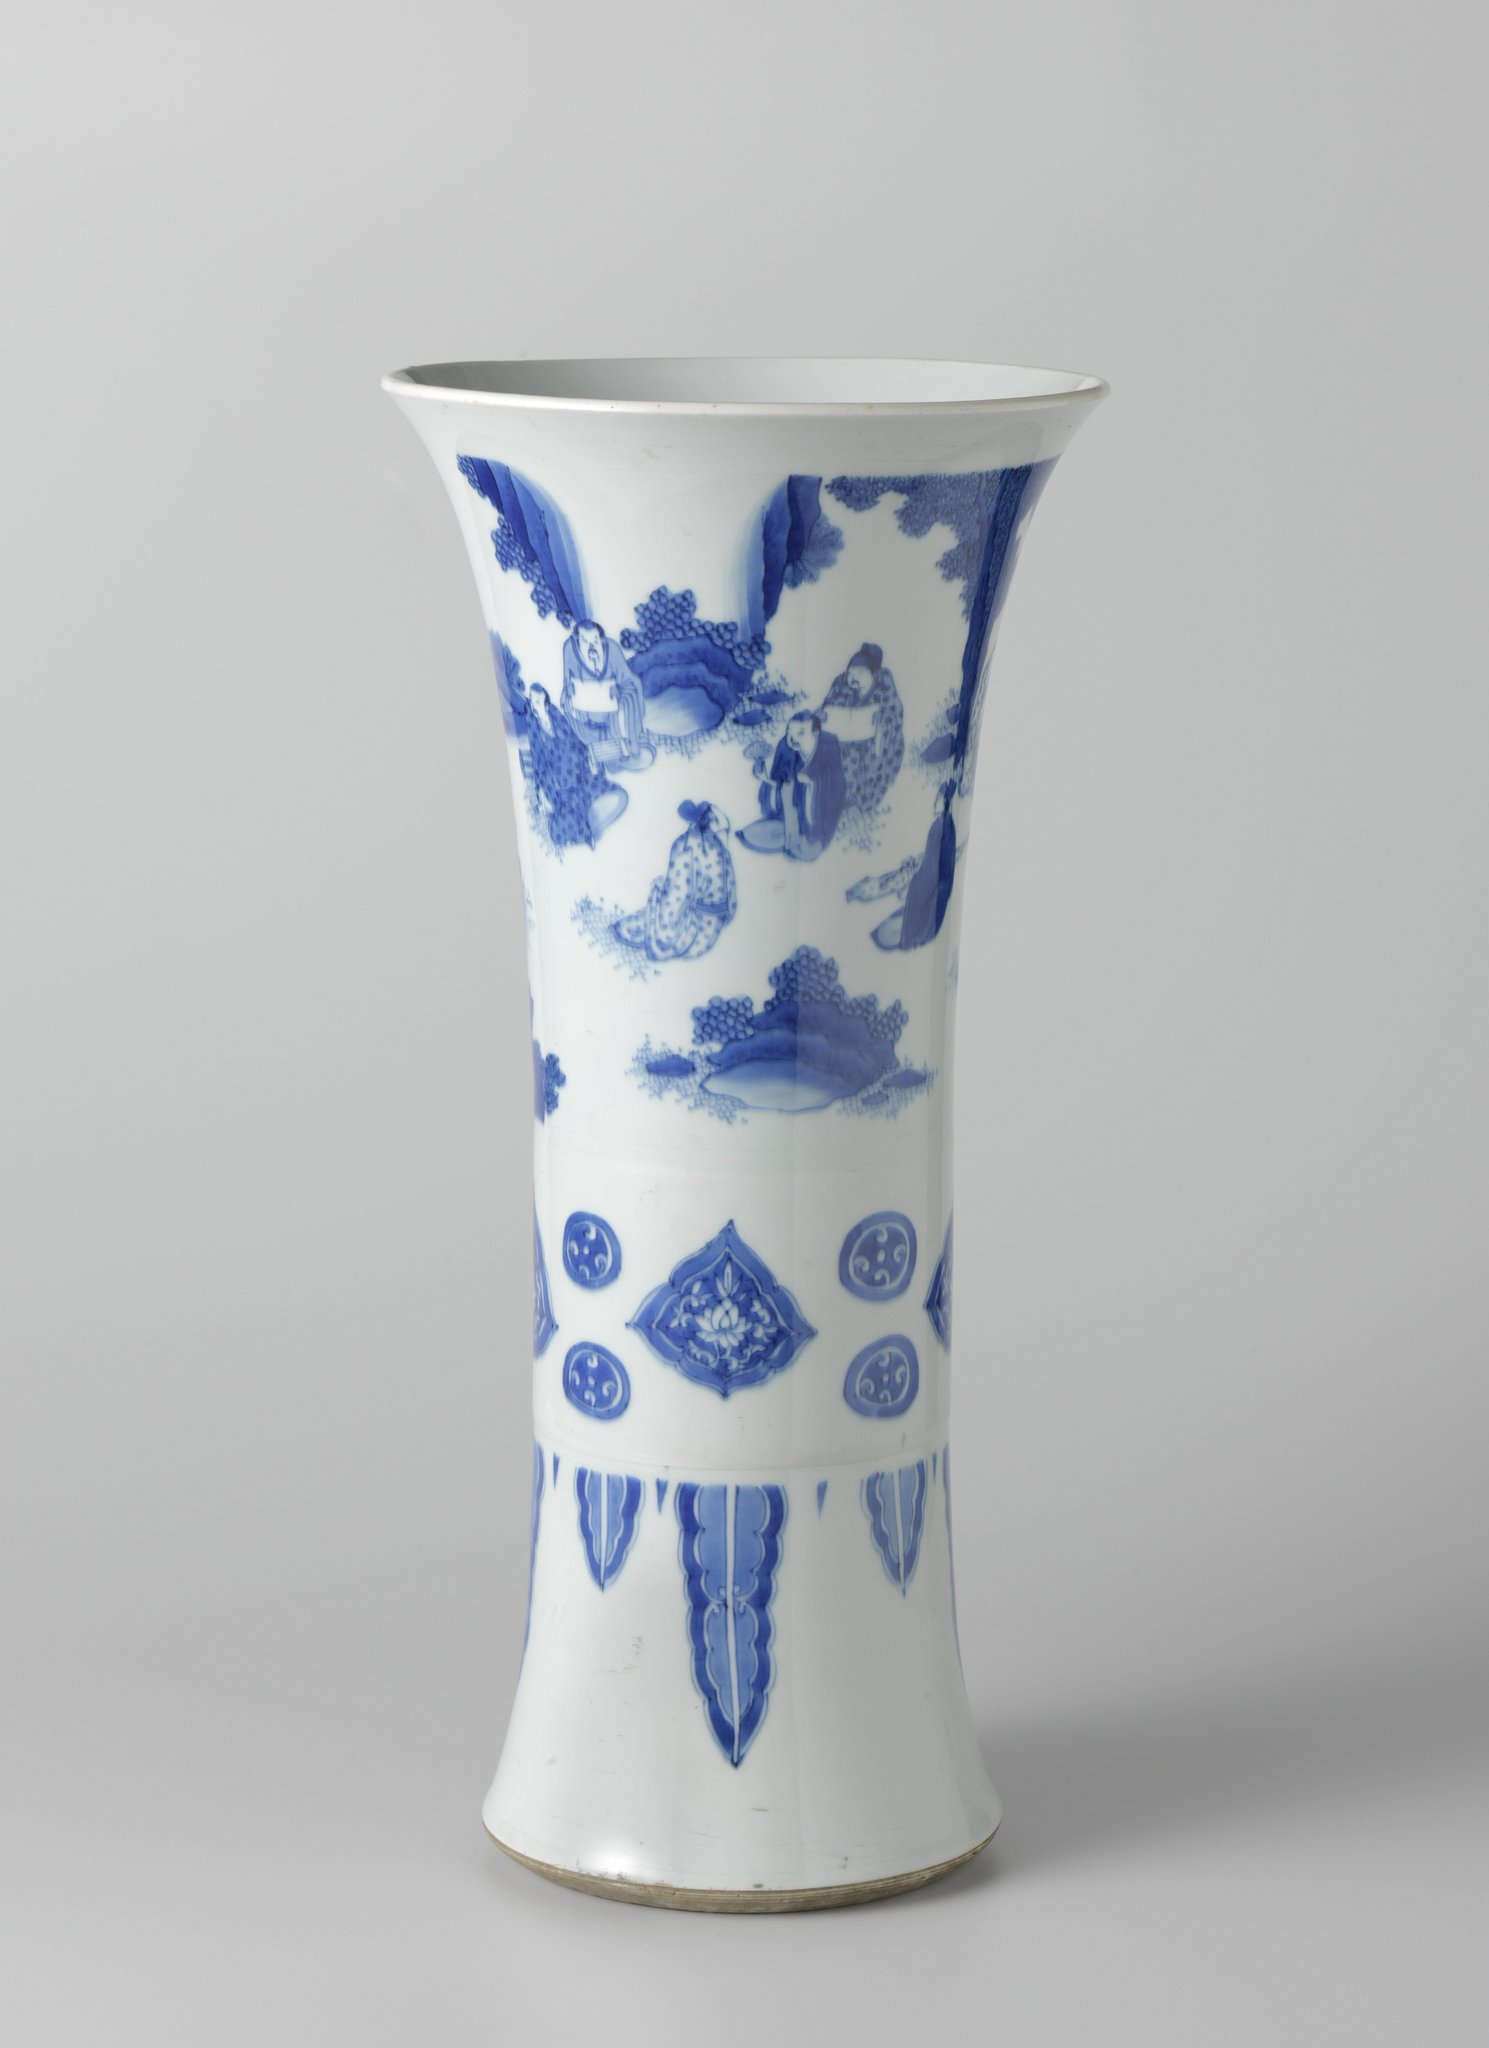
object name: vase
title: Beaker vase with scholars in a landscape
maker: Anonymous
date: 1635-1650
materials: cobalt, glaze, paint, porcelain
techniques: firing, turning, vitrification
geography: china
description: AK-NM-6658 Bekervaas • Overgangsporselein • Onderdeel van Royers porseleincollectie • Op de bodem in potlood: ‘No 22’. Betekenis niet bekend • Met dank aan Fan Lin, Qinxin He and Erika Riccobon, Universiteit Leiden, voor informatie over de voorstelling Het glazuur in deze vaas bevat iets teveel luchtbellen, zodat de voorstelling die overigens fraai en met aandacht voor details is geschilderd, niet scherp is. De bladmotieven in de onderste rand zijn niet precies regelmatig verdeeld over de ruimte. Het porselein dat nu bekend is als Overgangsporselein is voor een kieskeurige binnenlandse markt ontwikkeld. Maar omdat er ook een afzetmarkt was van internationale kopers die waarschijnlijk net iets minder op de kwaliteit letten, maar wel op de prijs, ontstond een grote groep van zeer redelijke, maar niet uitmuntende stukken. Een vaas als deze met een imperfect glazuur, was voor de export nog steeds goed genoeg. De voorstelling is echter bij uitstek toegesneden op goed cultureel onderlegde Chinese kopers. De negen mannen die op het bovenste deel van de vaas zijn afgebeeld zijn de negen oudere geleerde heren die zich in 845, het vijfde jaar van de Huichang-periode (841-845) uit het openbare leven terugtrokken uit onvrede over de corruptie aan het keizerlijke hof. Zij kwamen samen op de ‘Fragrant Mountain’. Het is een van de vele varianten van het steeds terugkerende thema binnen de decors op Overgangsporselein. We zien de geleerden afgebeeld terwijl ze zich bezighouden met voor hen passende bezigheden: het lezen van poëzie of het bekijken van een schildering, het bespelen van de luit; twee mannen hebben waarschijnlijk een waaier in de hand. Het thema van de negen oude geleerden op de ‘Fragrant Mountain’ was bekend uit de schilderkunst – zie hiervoor een vroeg voorbeeld door Xie Huan (ca. 1346-1430).